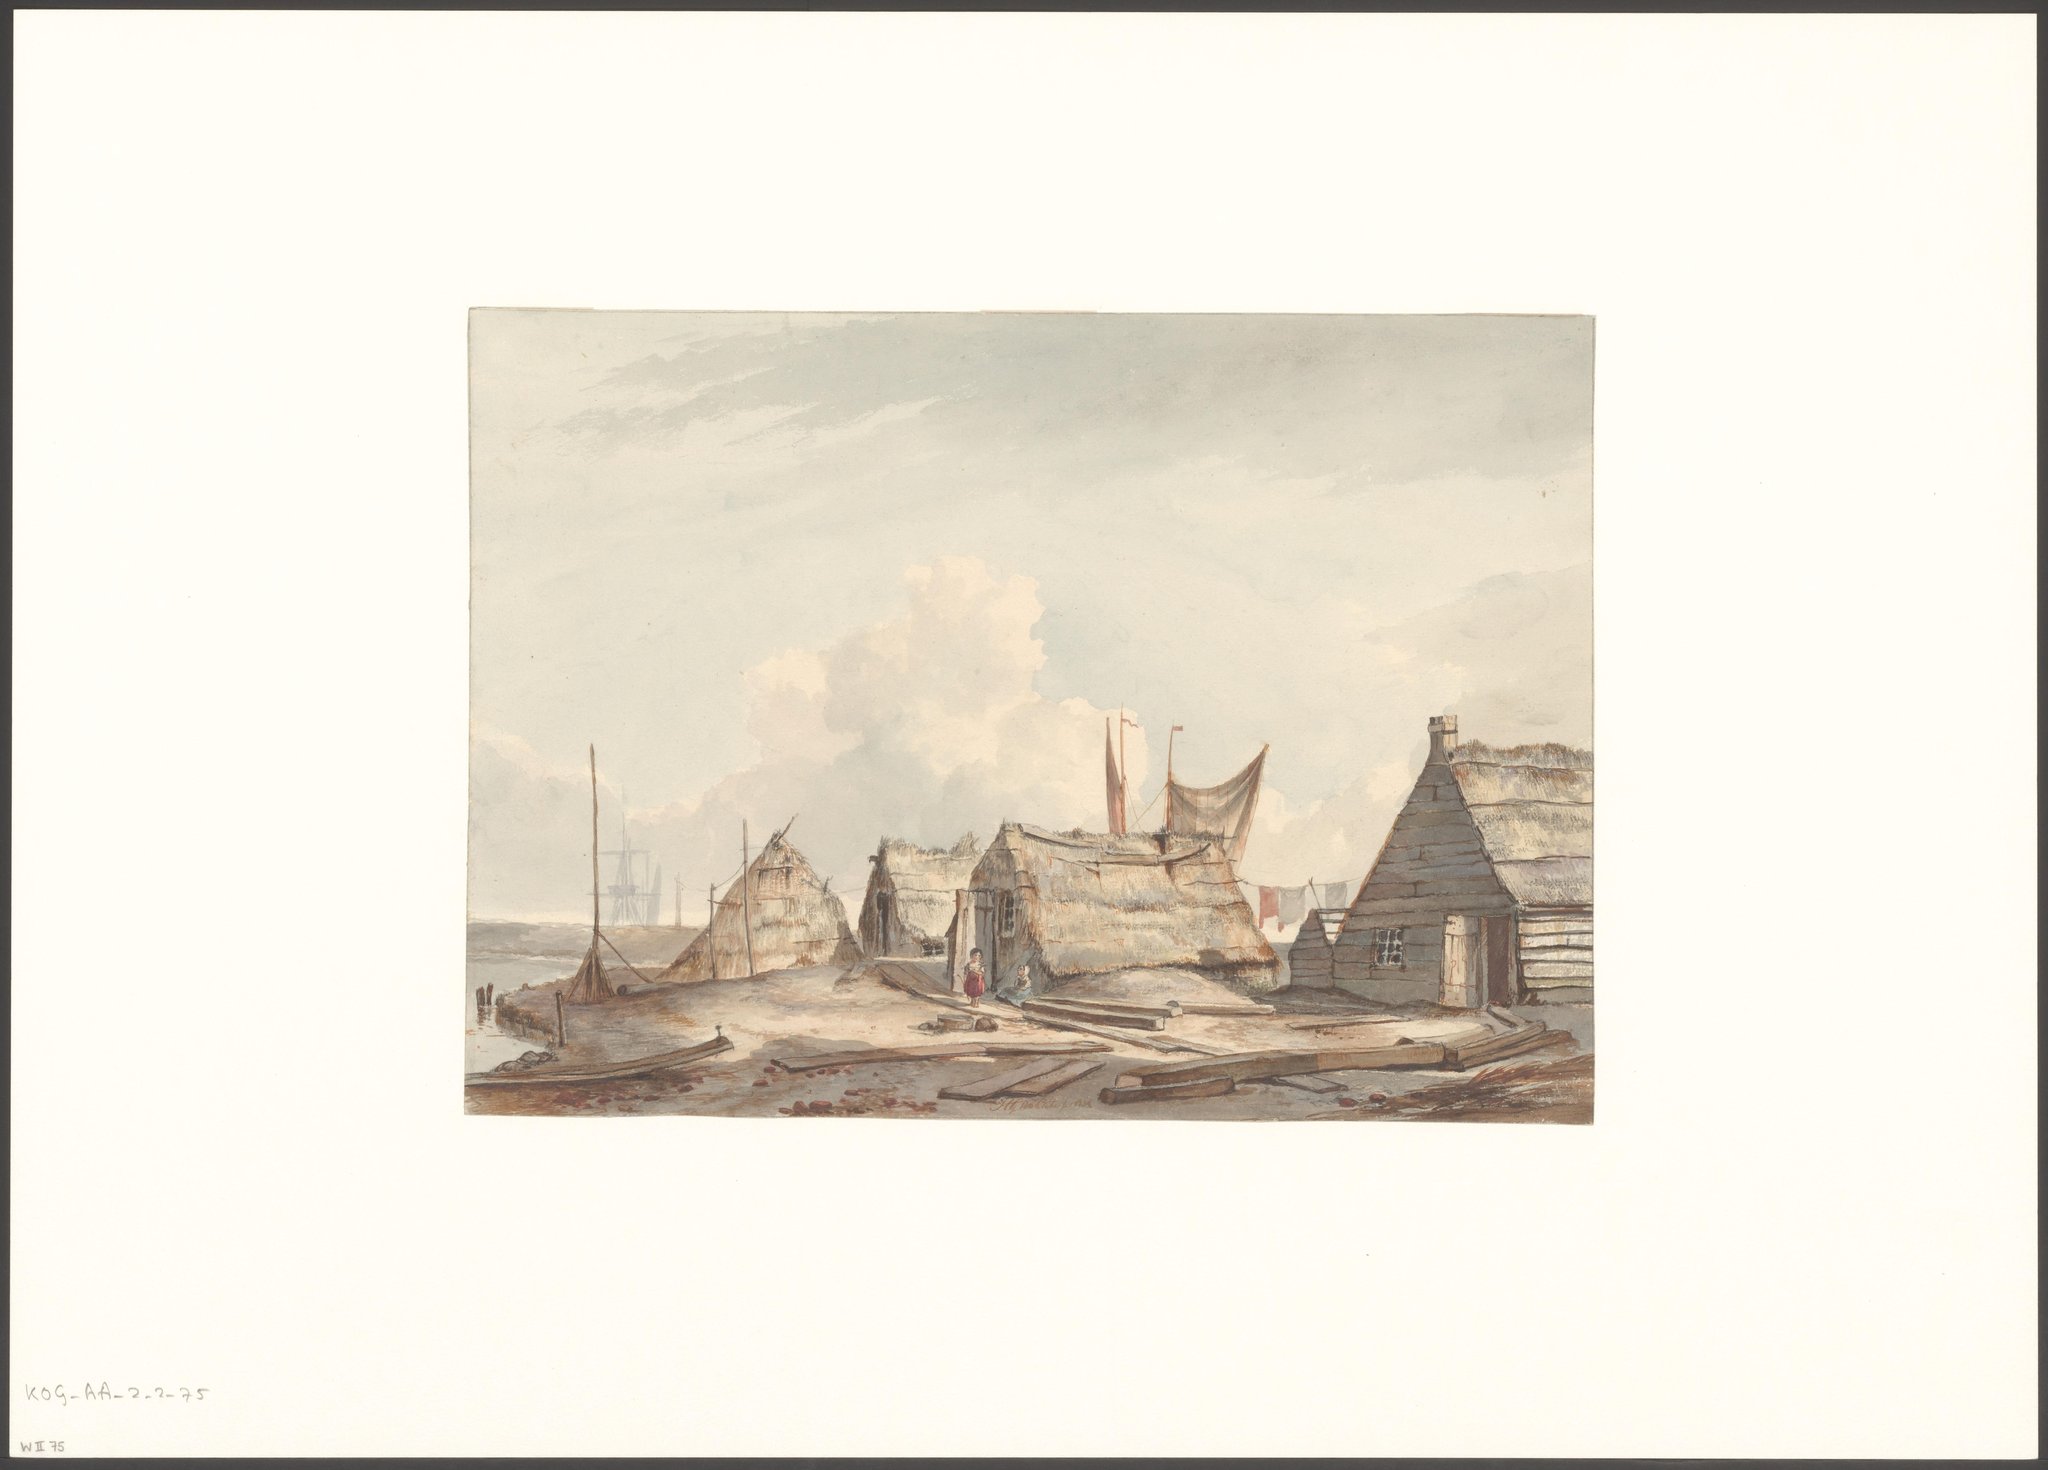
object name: drawing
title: Gezicht op de Westerdoksdijk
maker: hendrik gerrit ten cate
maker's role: draughtsman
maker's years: 1803-1856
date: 1834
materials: ink, paper, pencil, watercolor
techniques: brush, pen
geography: amsterdam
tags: sailing-ship, sailing-boat, city-view in general; 'veduta', hut, cabin, lodge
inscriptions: collector's mark: Lugt 800a, : ‘De aanleg van den Westerdoksdijk.’, signature and date: ‘HGtenCate1834’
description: Tekening binnen de Atlas Van Eck ingedeeld op wijknummer 2.